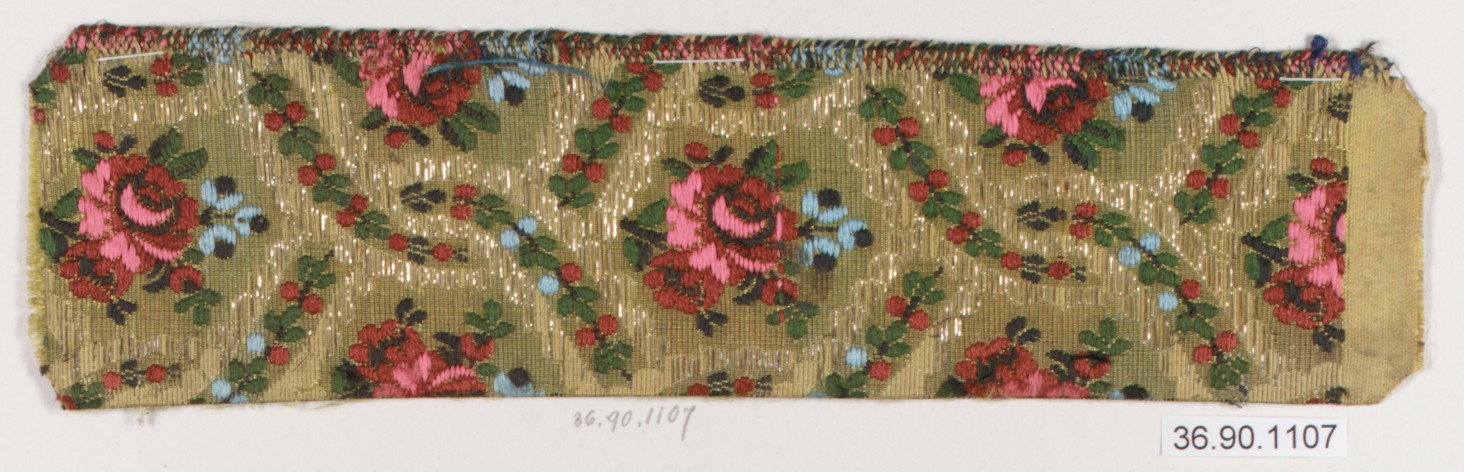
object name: sample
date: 1701-1900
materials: metal thread, silk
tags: flowers